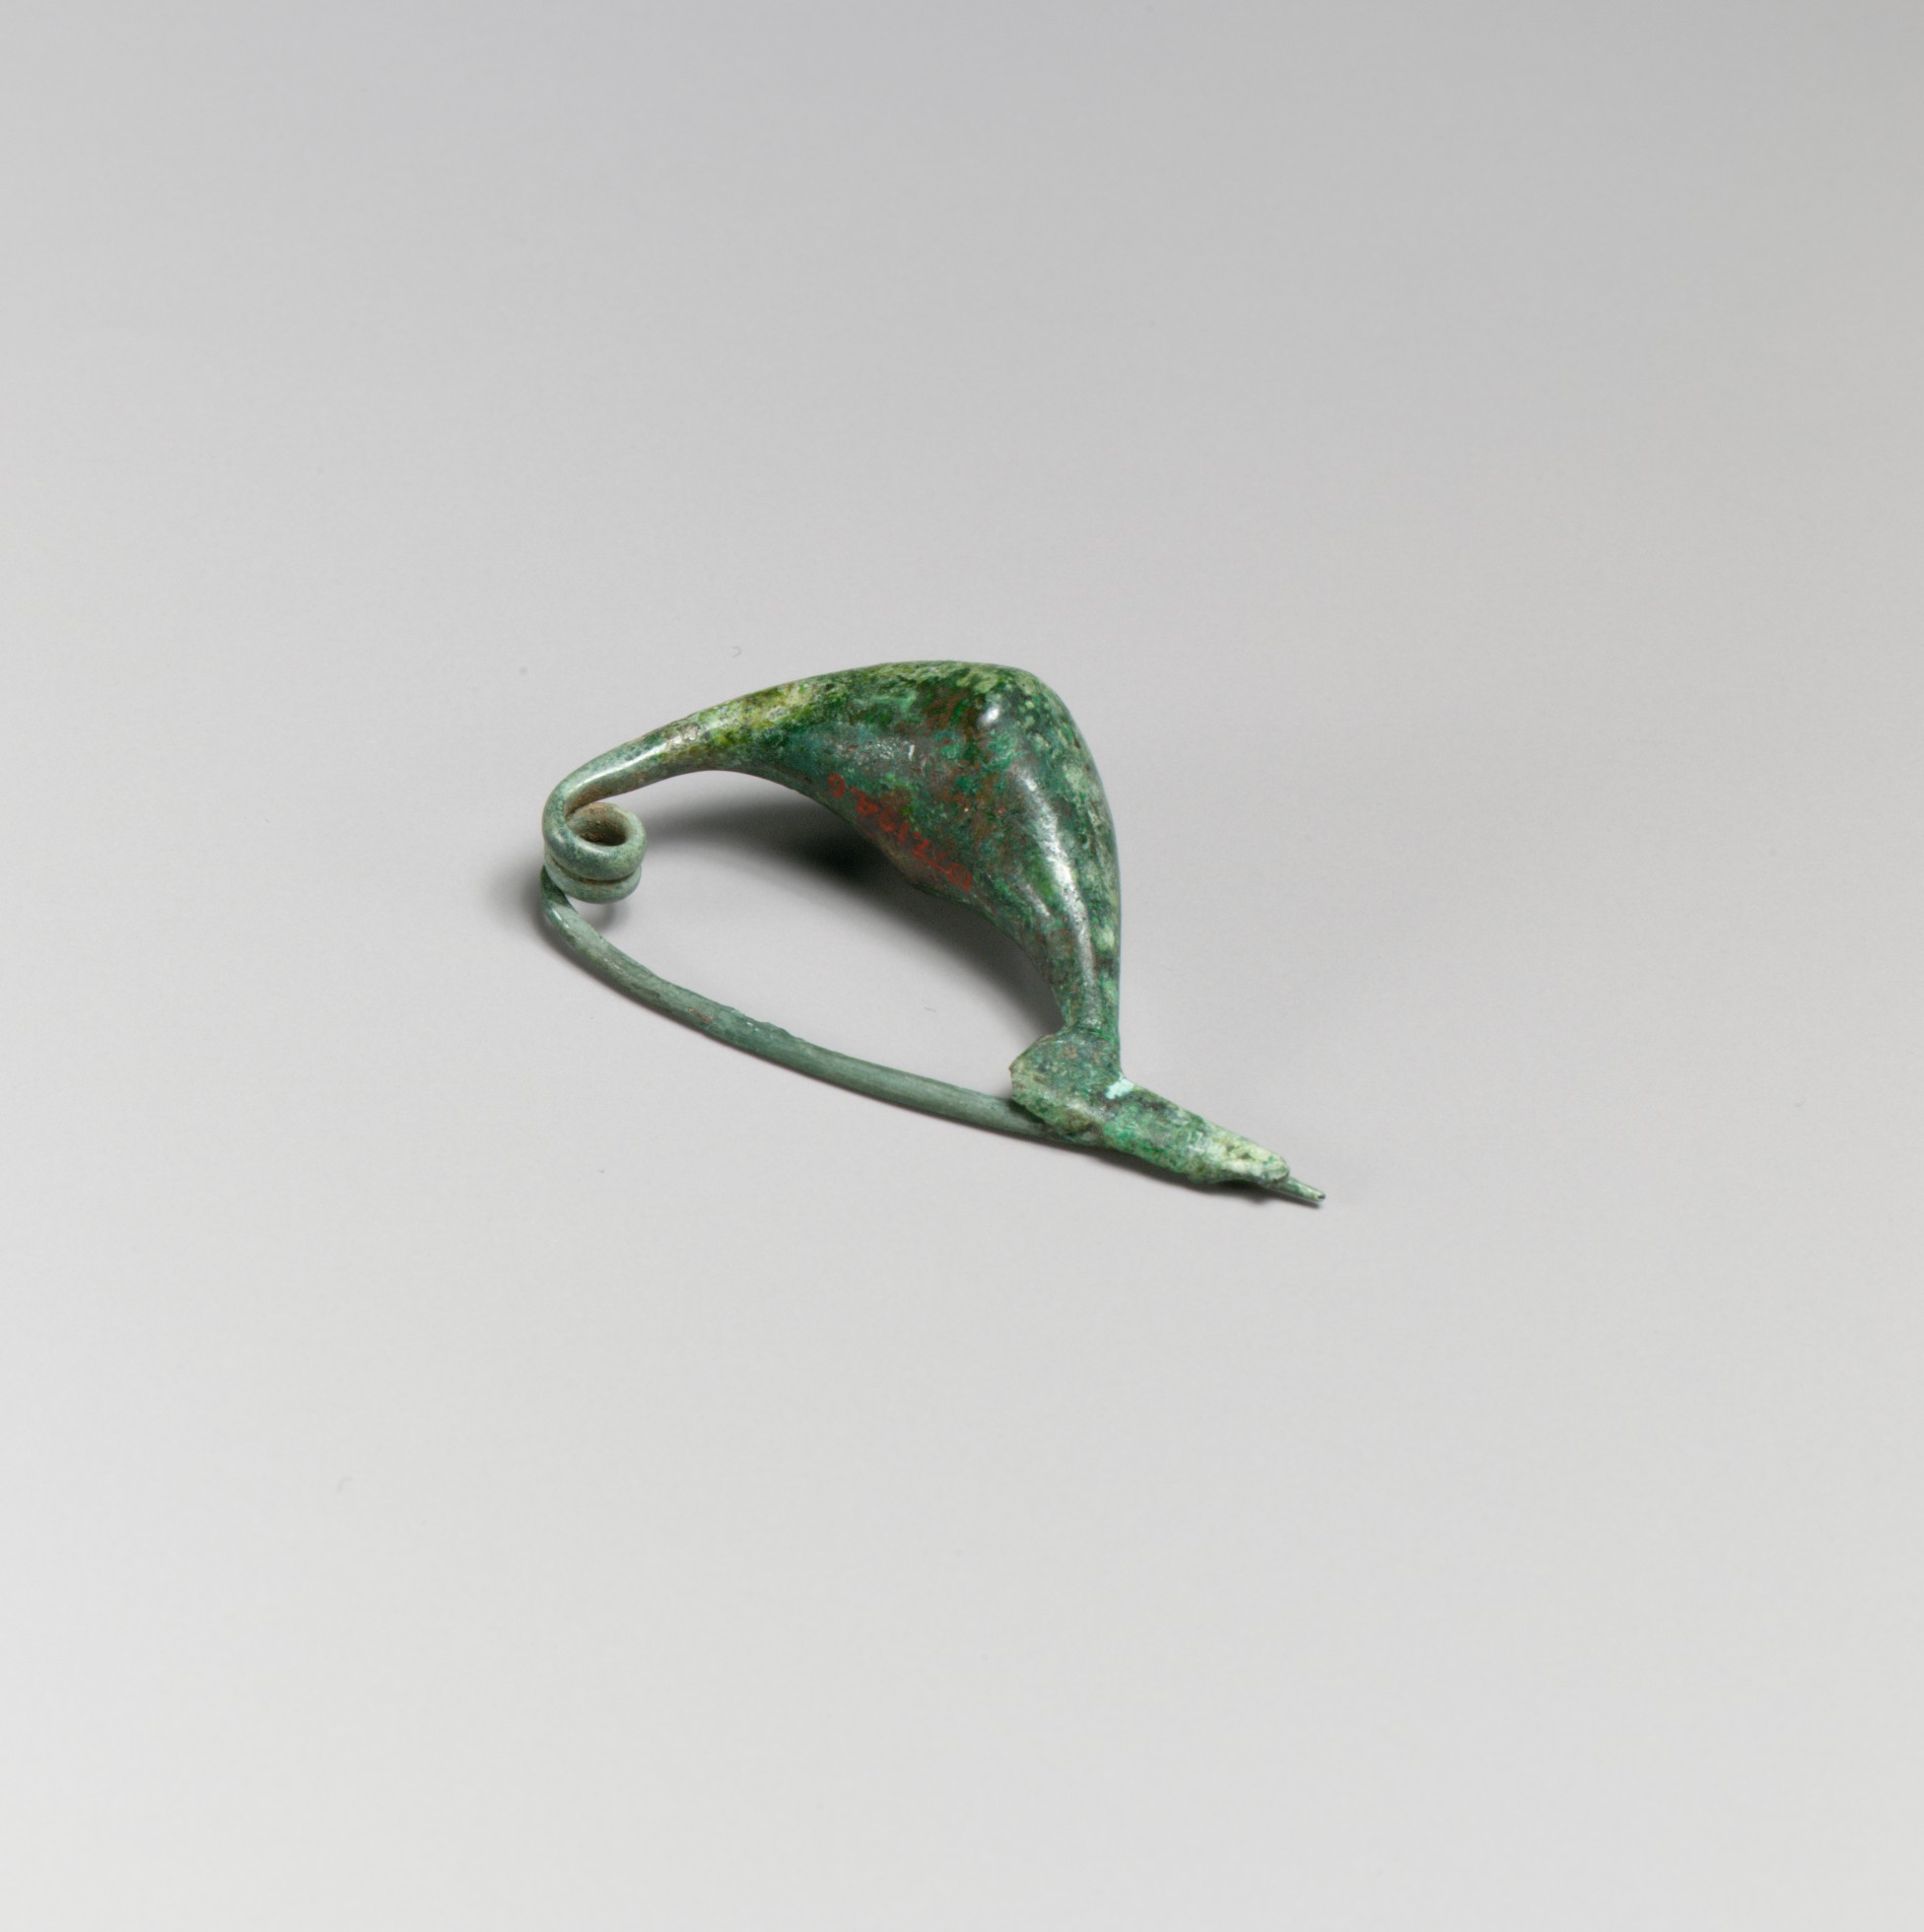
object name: fibula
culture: etruscan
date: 700-601 BCE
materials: bronze